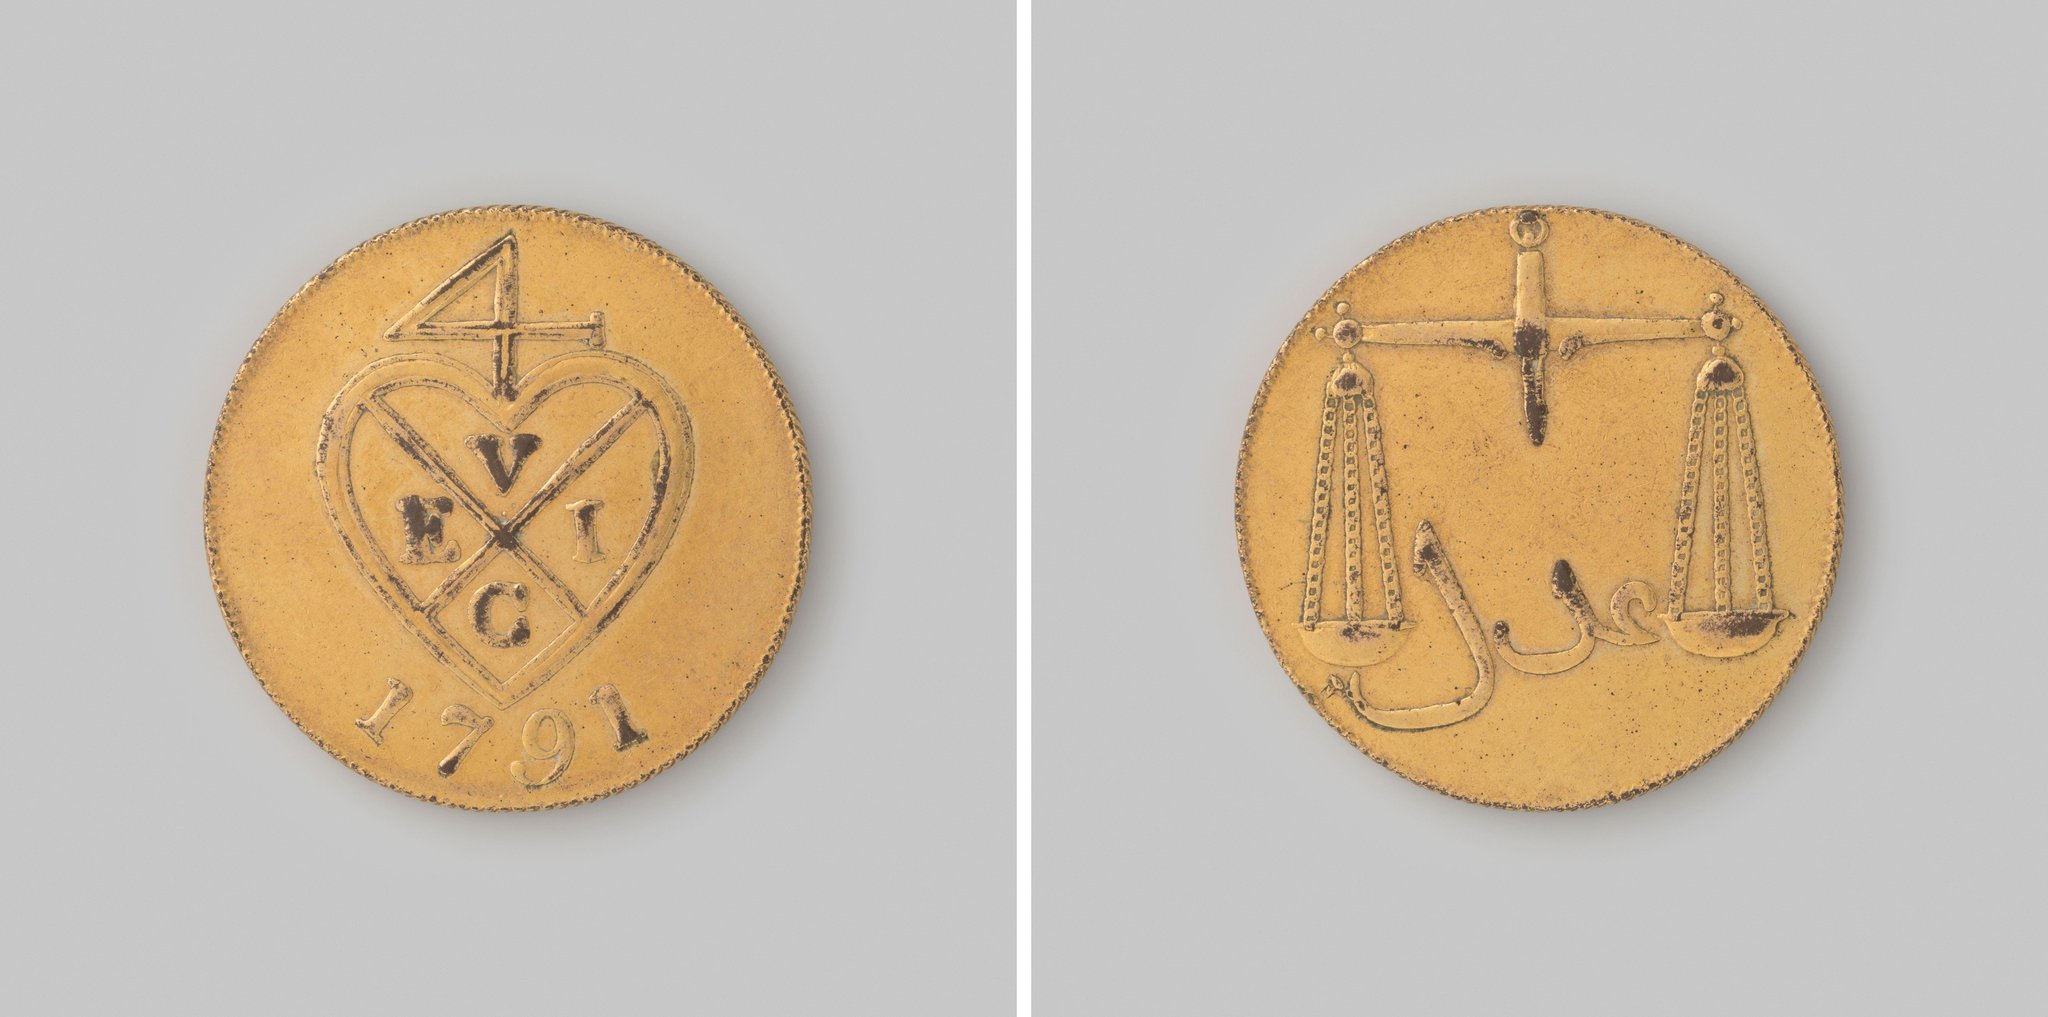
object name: coin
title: Dubbele Pice voor Bombay in India van de Engelse Oostindische Compagnie (EIC), 1791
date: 1791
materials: copper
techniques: striking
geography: birmingham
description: Verguld-koperen munt. Voorzijde: merk van de EIC met onderaan jaartal. Keerzijde: weegschaal met tussen de twee schalen opschrift in Arabische lettertekens: adl [=rechtvaardig]. Kabelrand